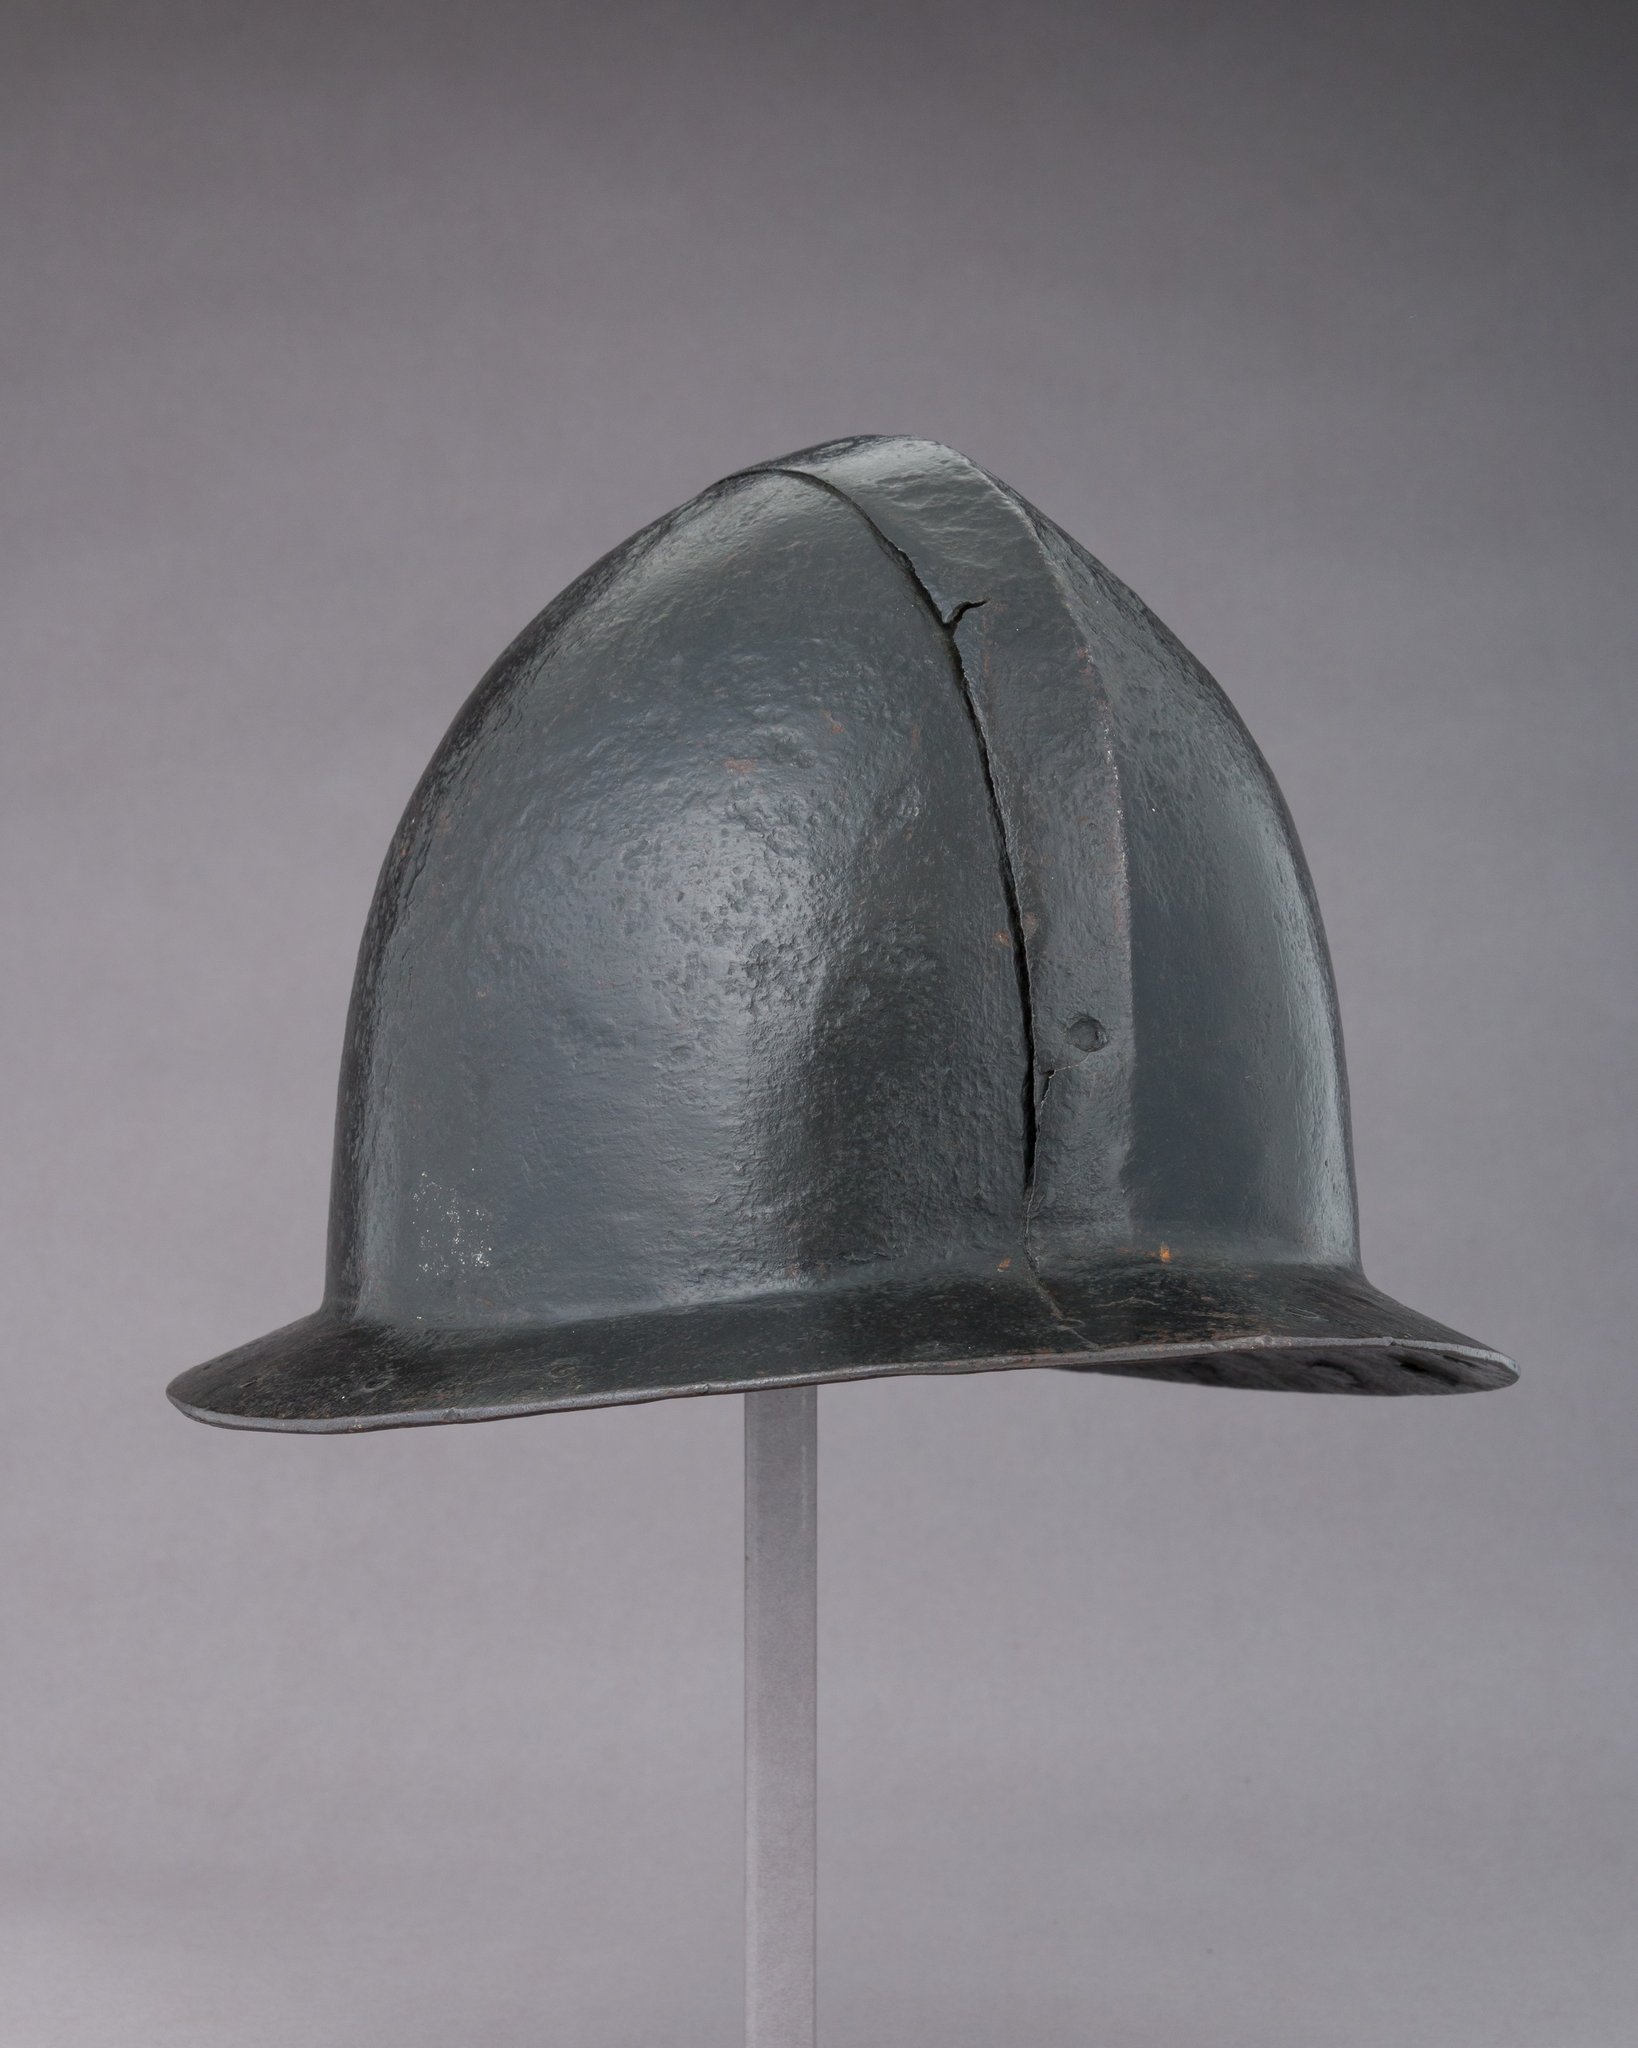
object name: siege helmet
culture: french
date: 1601-1700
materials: steel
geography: france